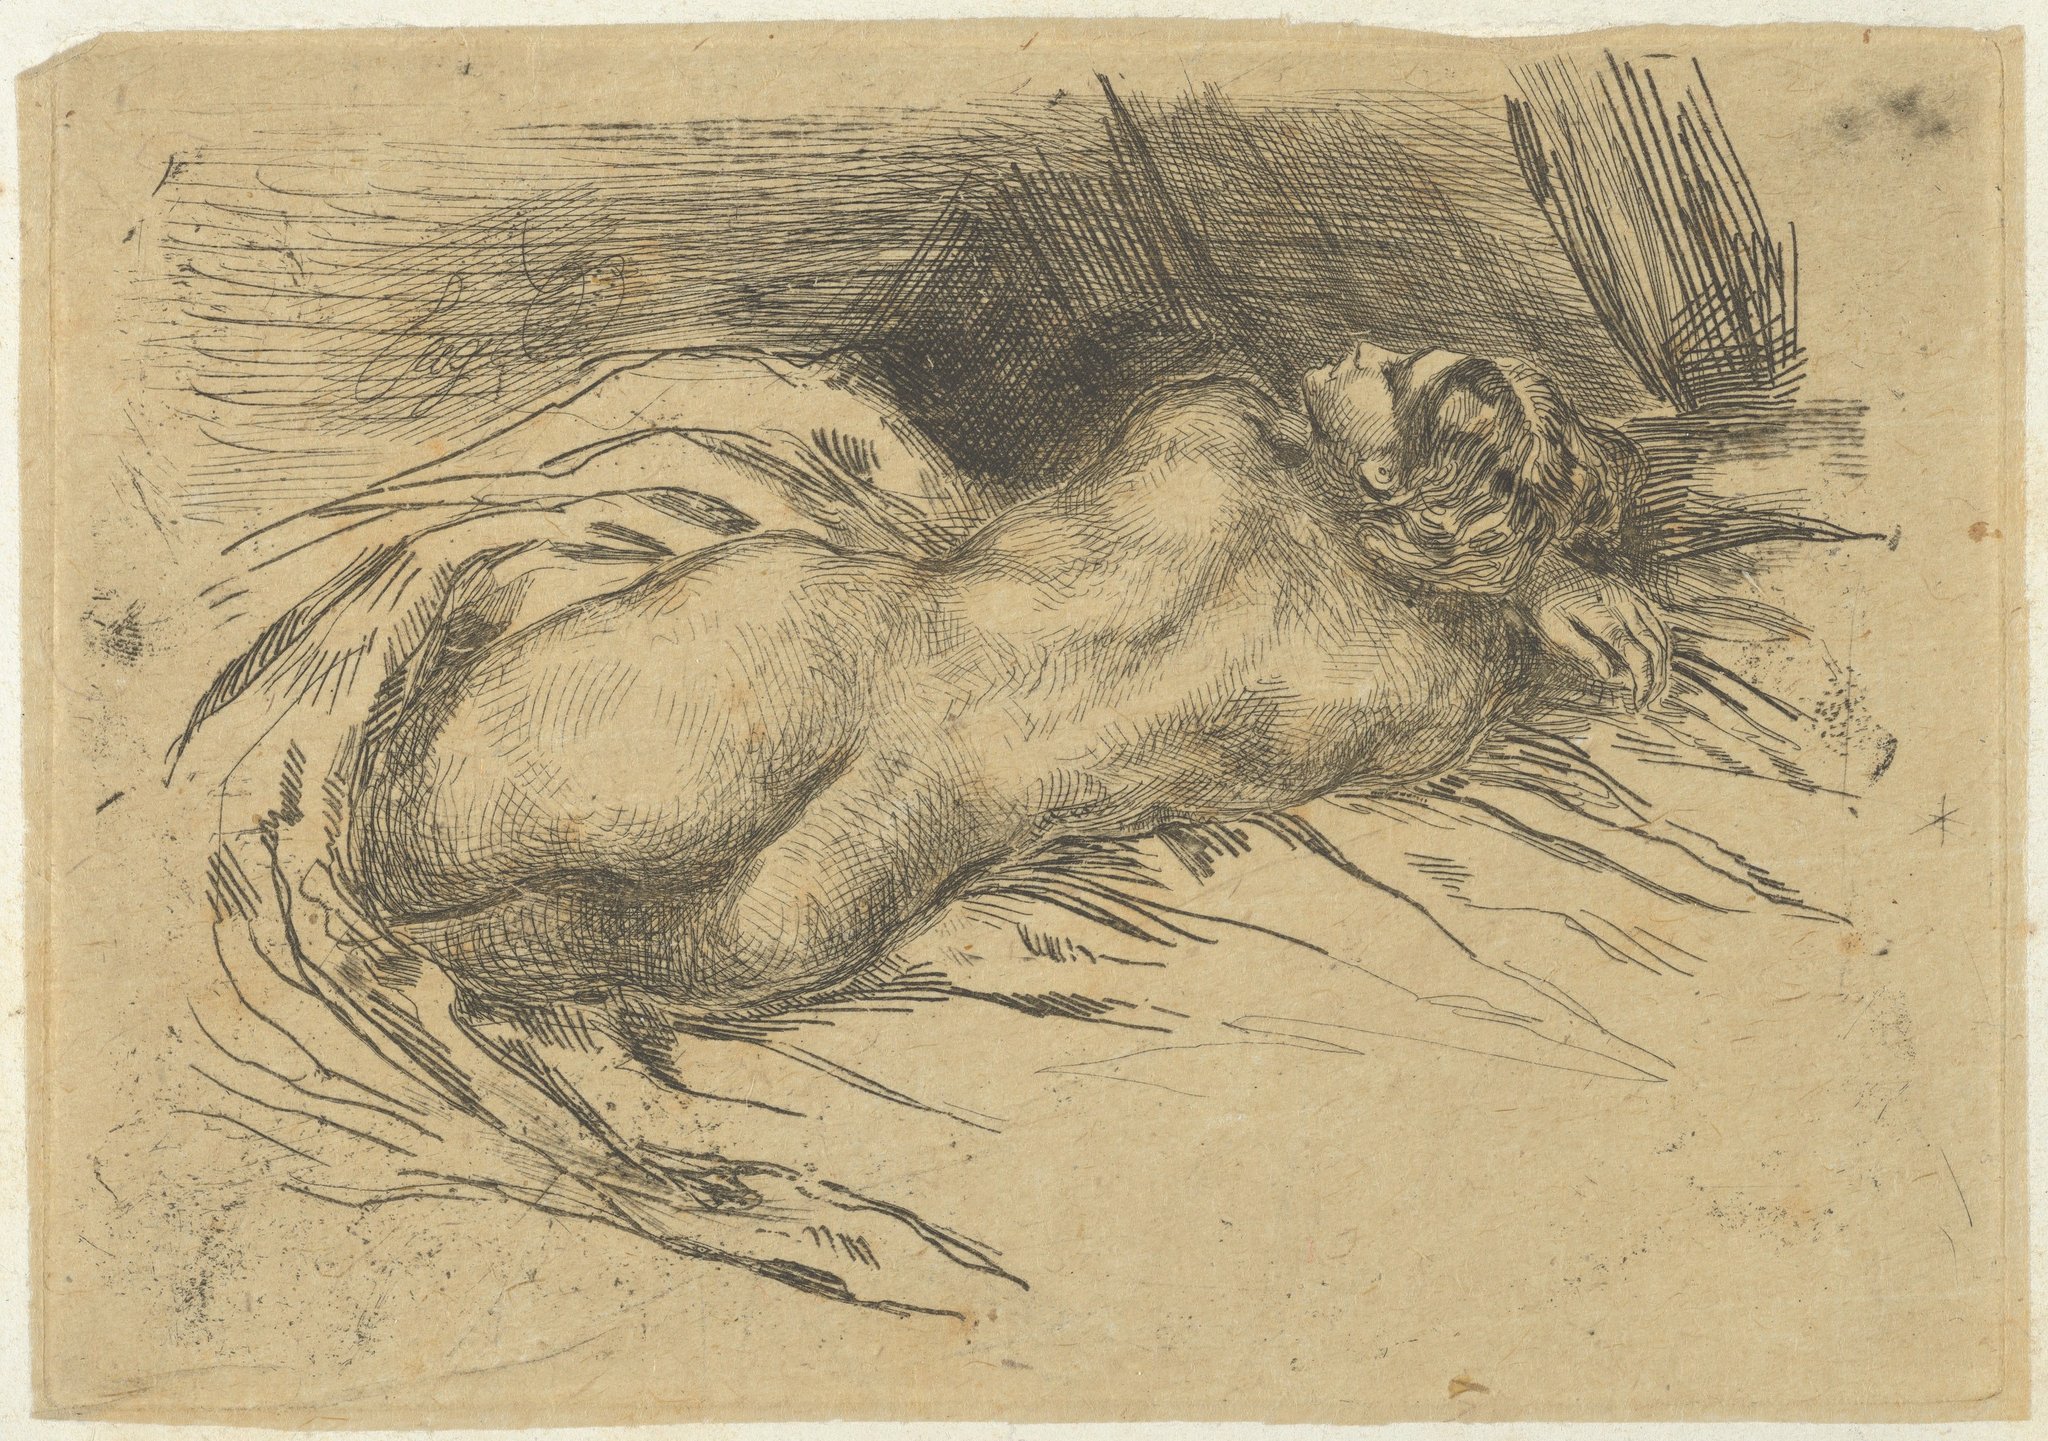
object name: print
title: Study of a Woman Viewed from Behind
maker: eugène delacroix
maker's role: artist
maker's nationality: french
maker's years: 1798-1863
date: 1833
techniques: printmaking, etching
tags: female nudes